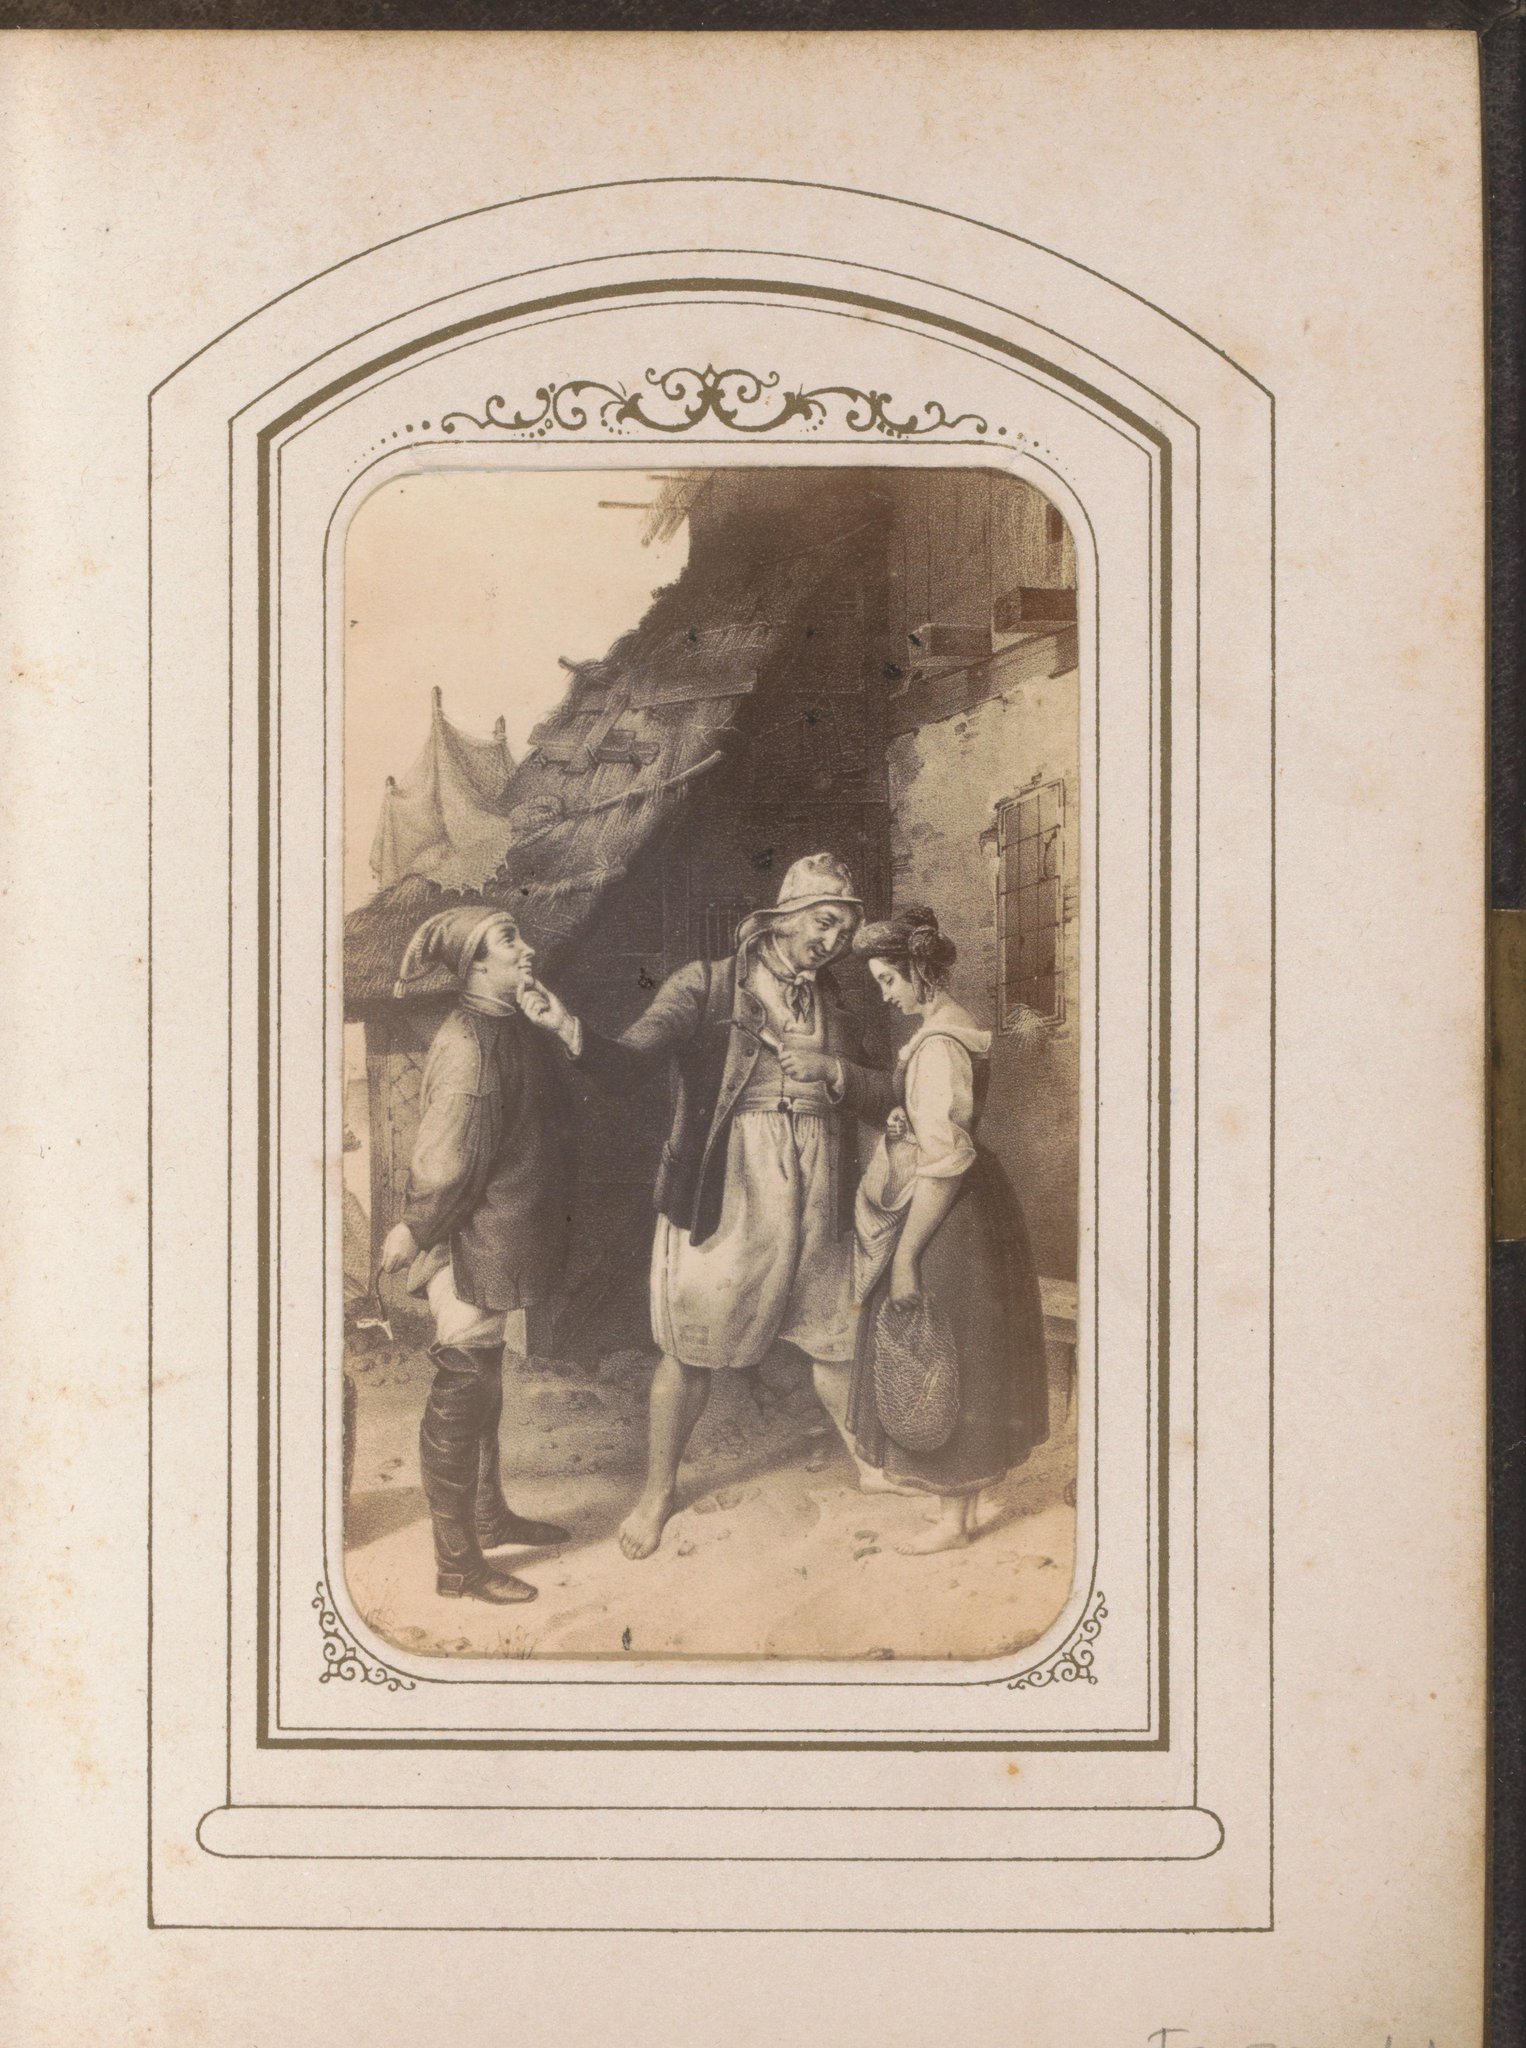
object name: photograph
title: Fotoreproductie van (vermoedelijk) een prent naar een schilderij van Rudolf Jordan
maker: Anonymous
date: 1860-1890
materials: cardboard, paper, photographic support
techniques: albumen print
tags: proposal, declaration of love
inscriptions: inscription: ‘Le proposition in Helgolande’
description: Onderdeel van Fotoalbum met 36 opnames van Europese landen.